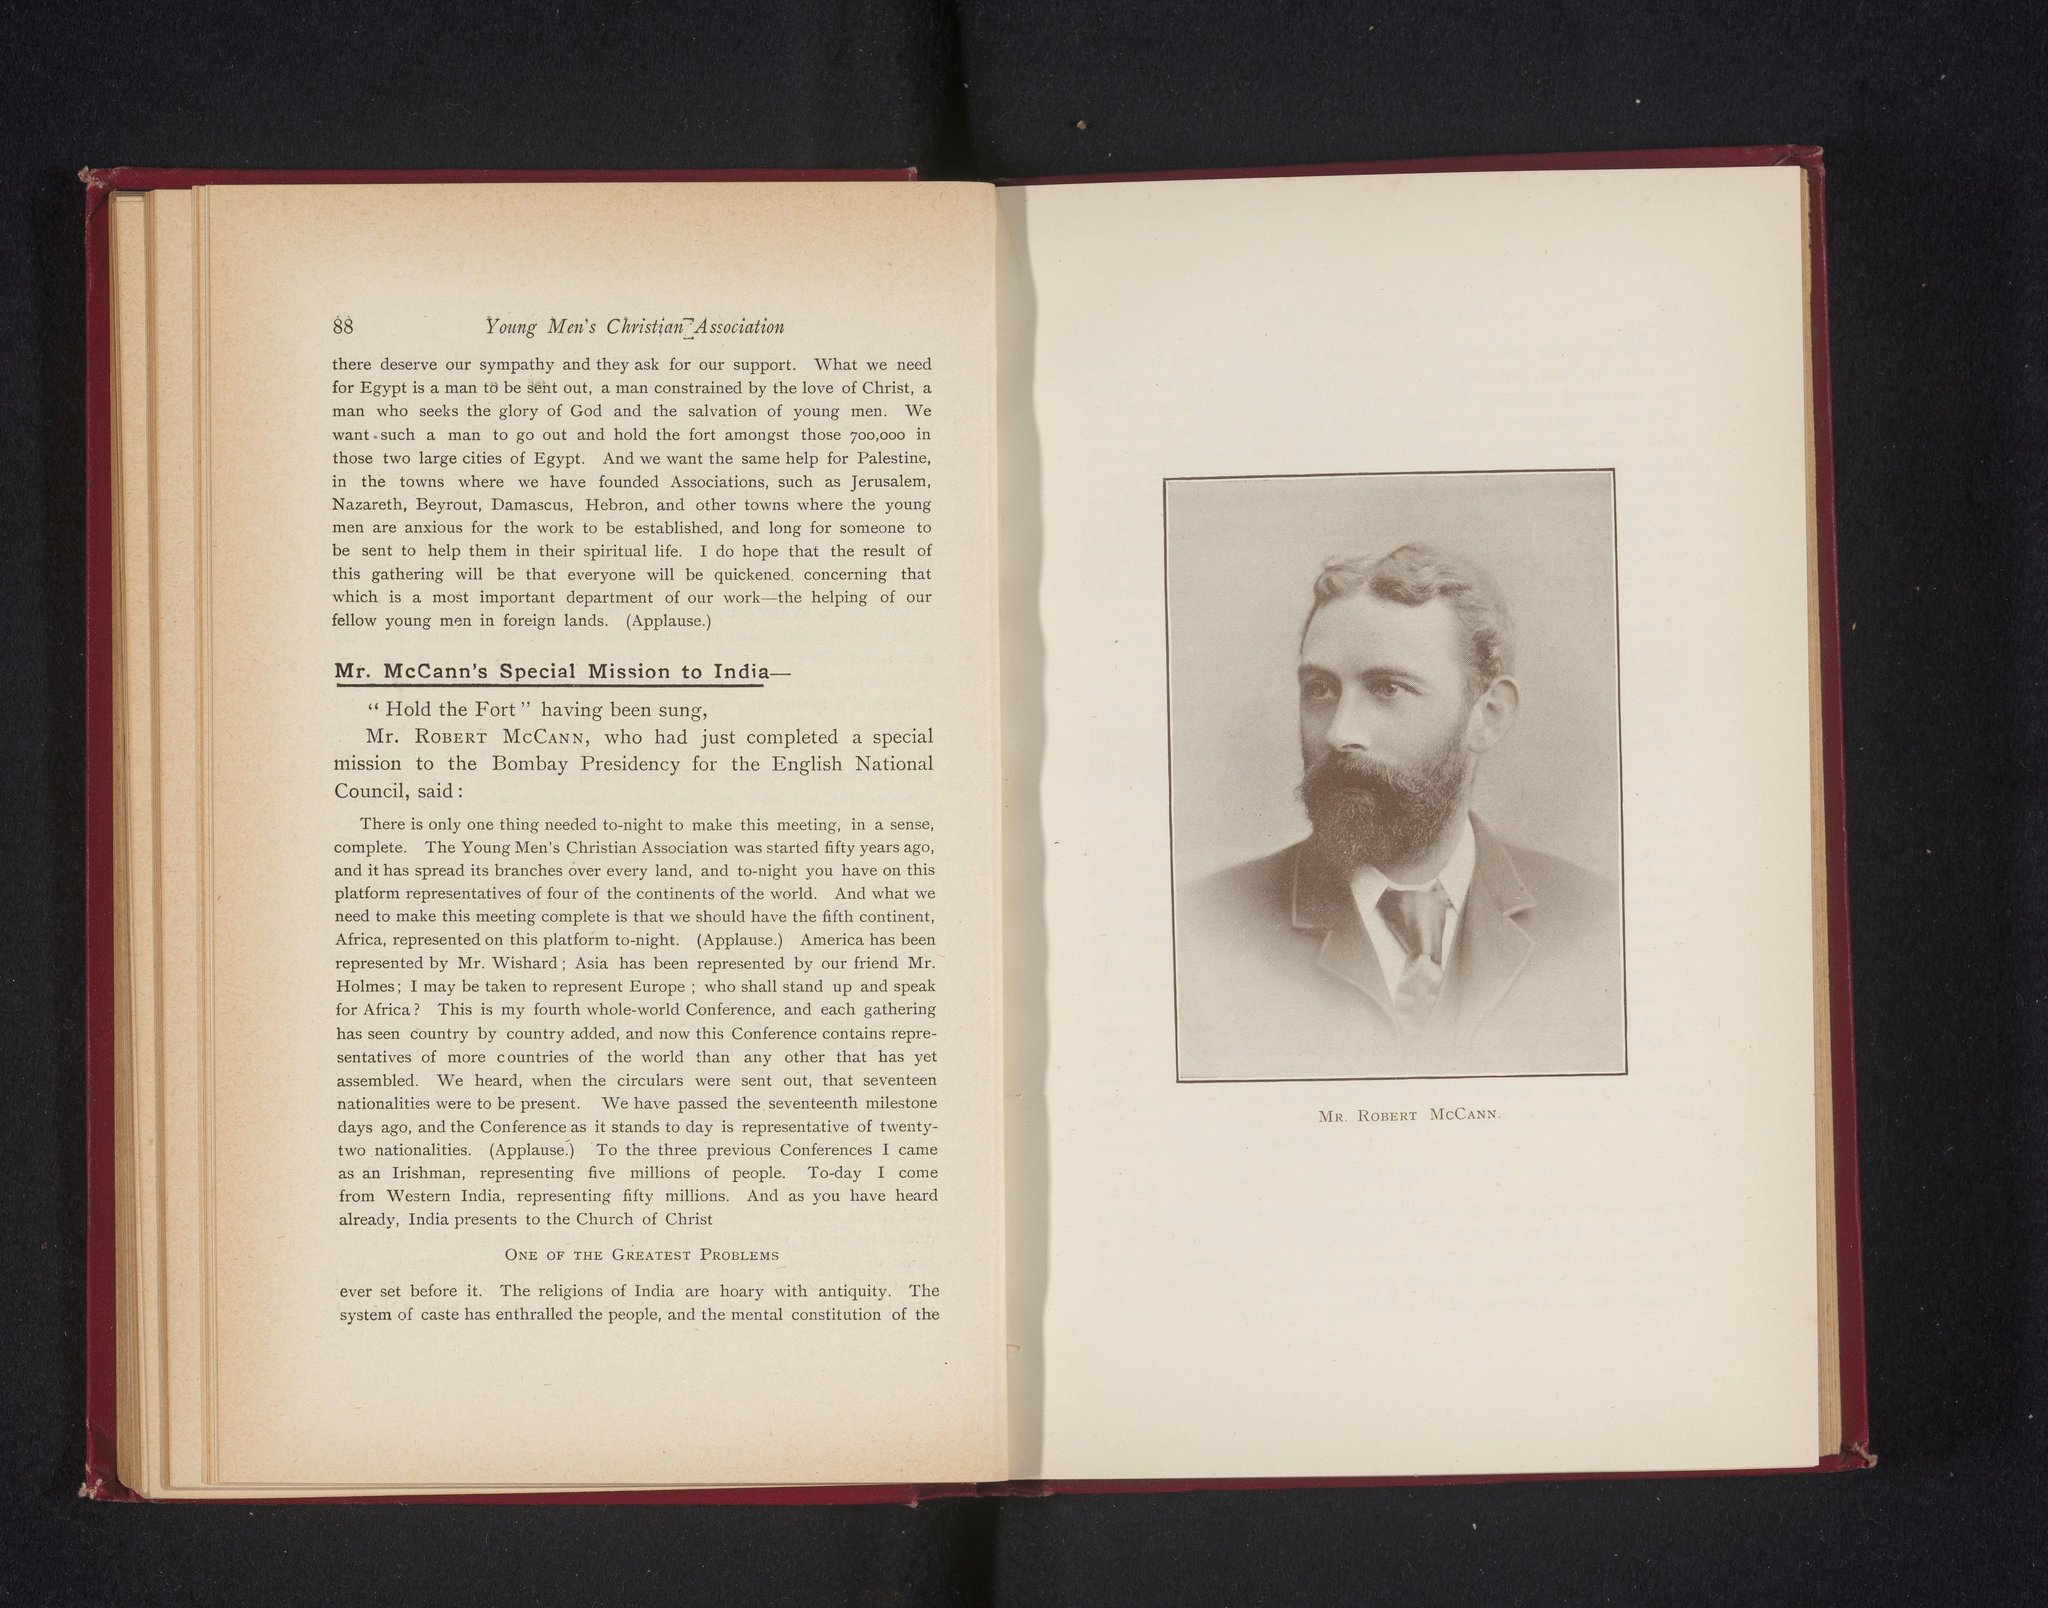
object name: page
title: Portret van Robert McCann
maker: Anonymous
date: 1890-1895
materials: paper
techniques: autotype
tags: historical persons